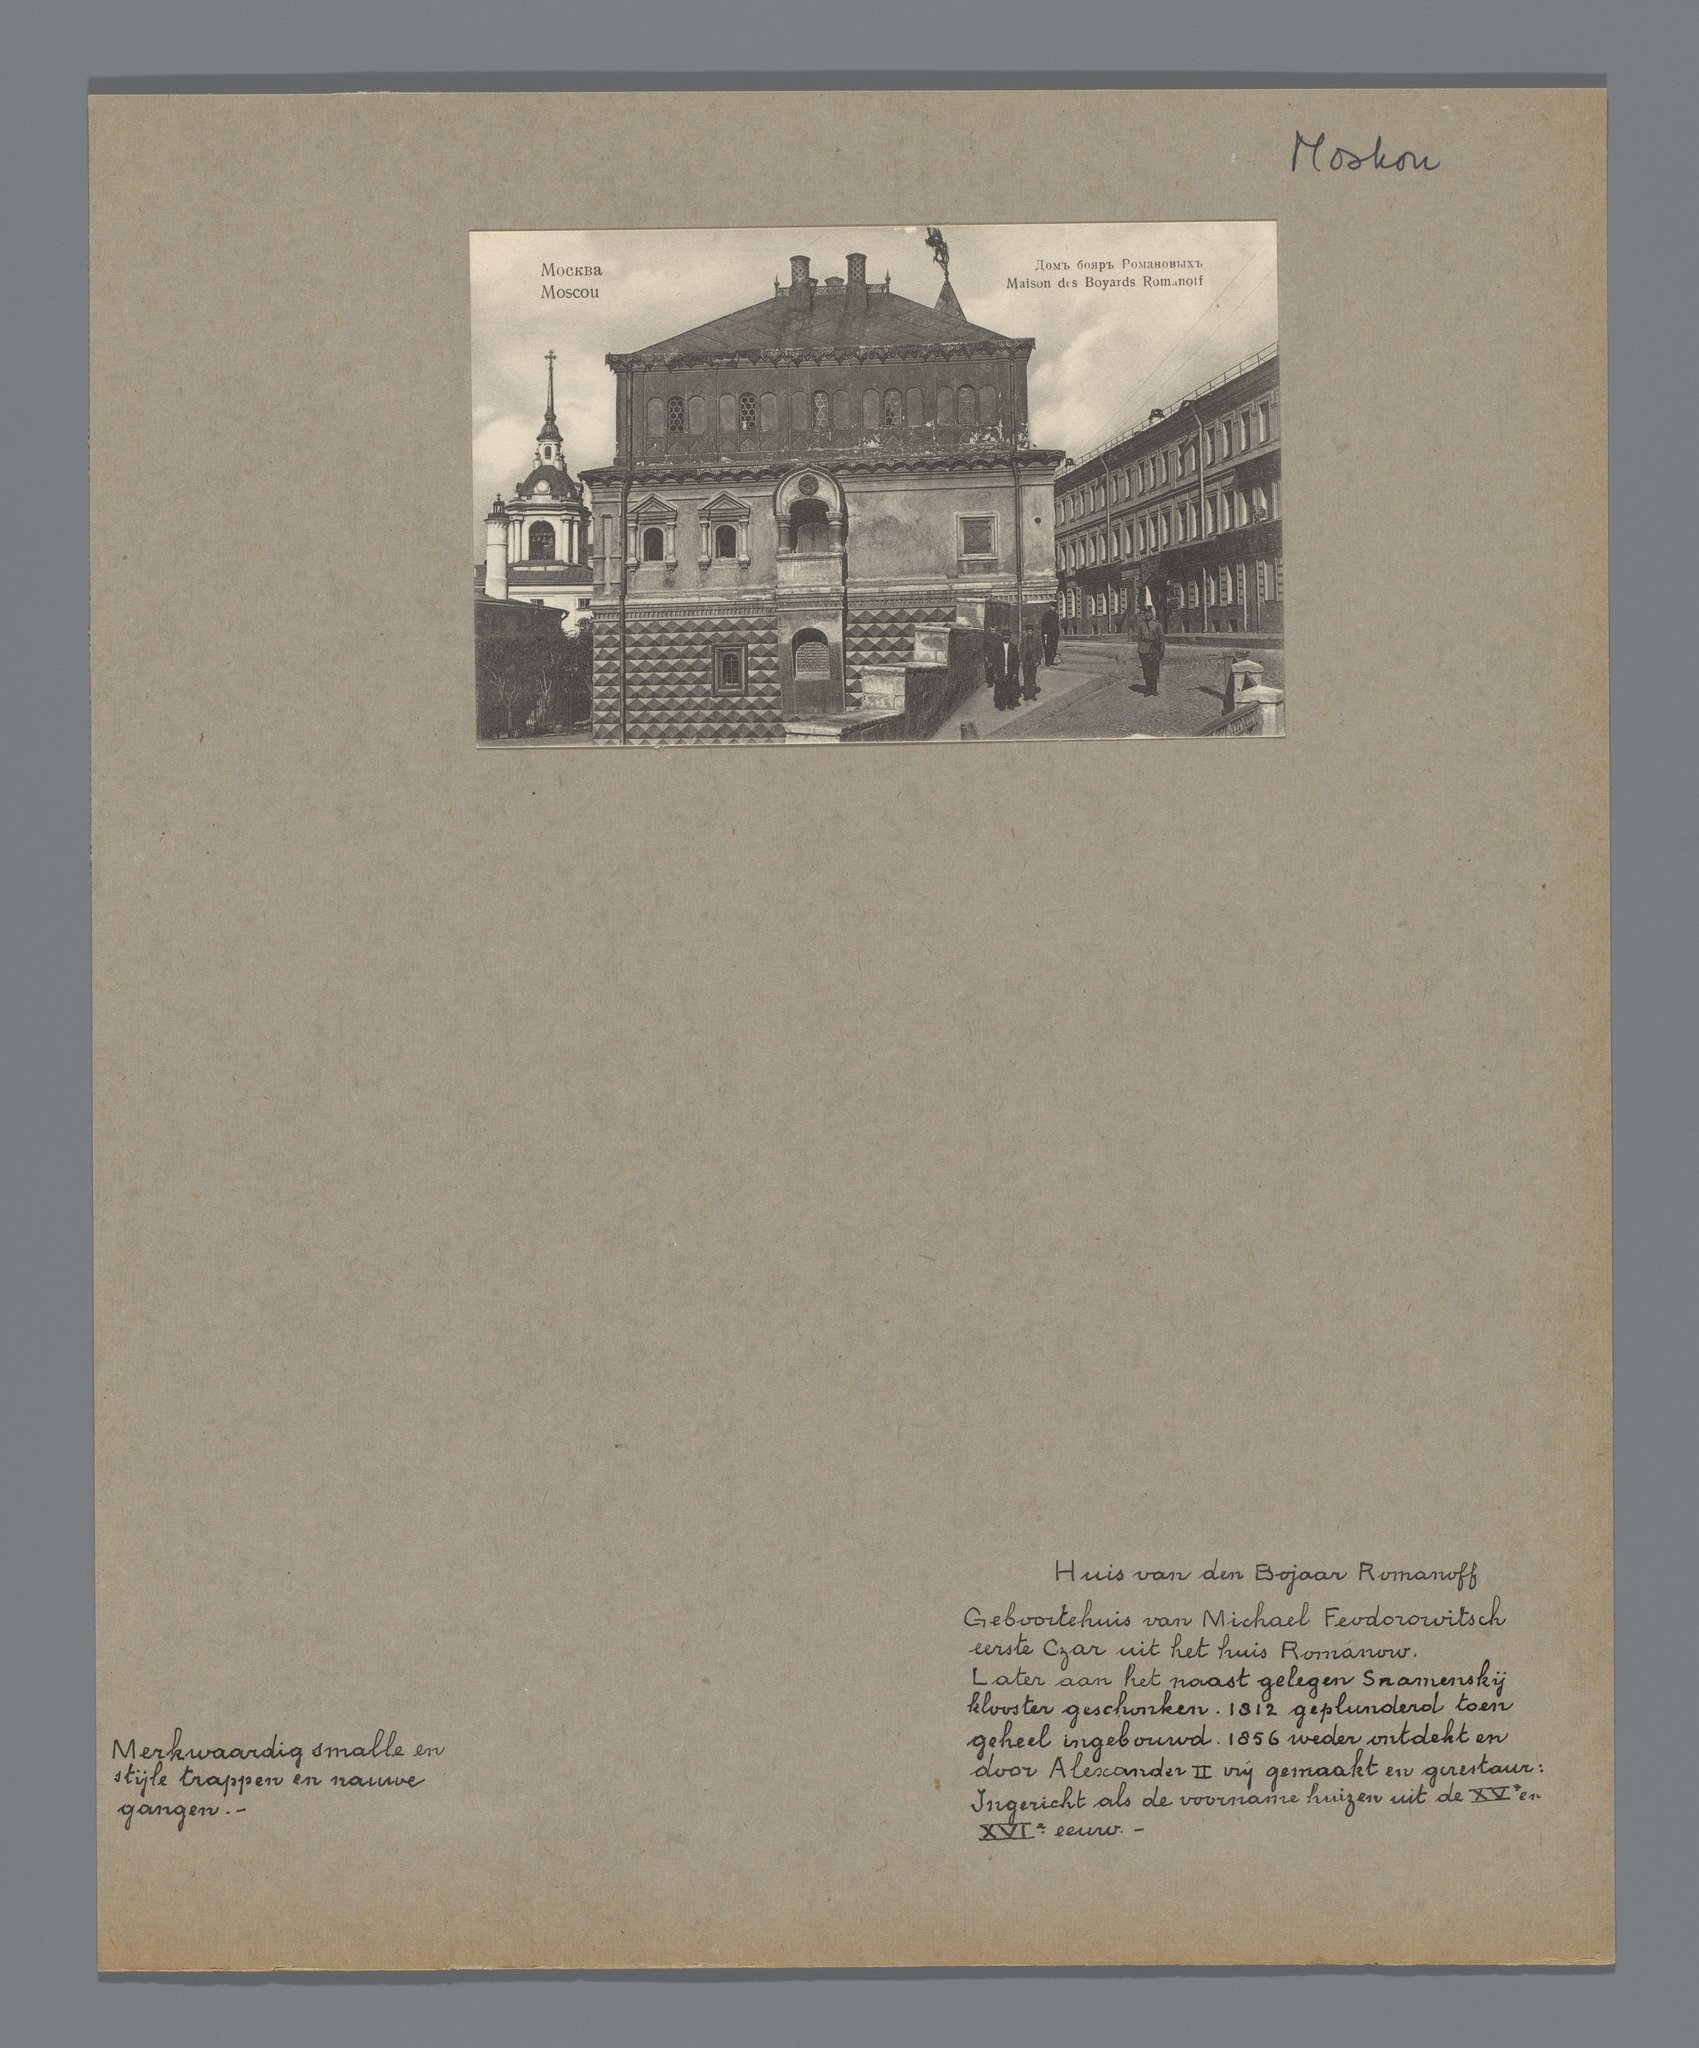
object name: photograph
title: Moskou. Huis van Bojaar Romanof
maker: Anonymous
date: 1860-1925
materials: photographic support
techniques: photograph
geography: russia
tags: moskou